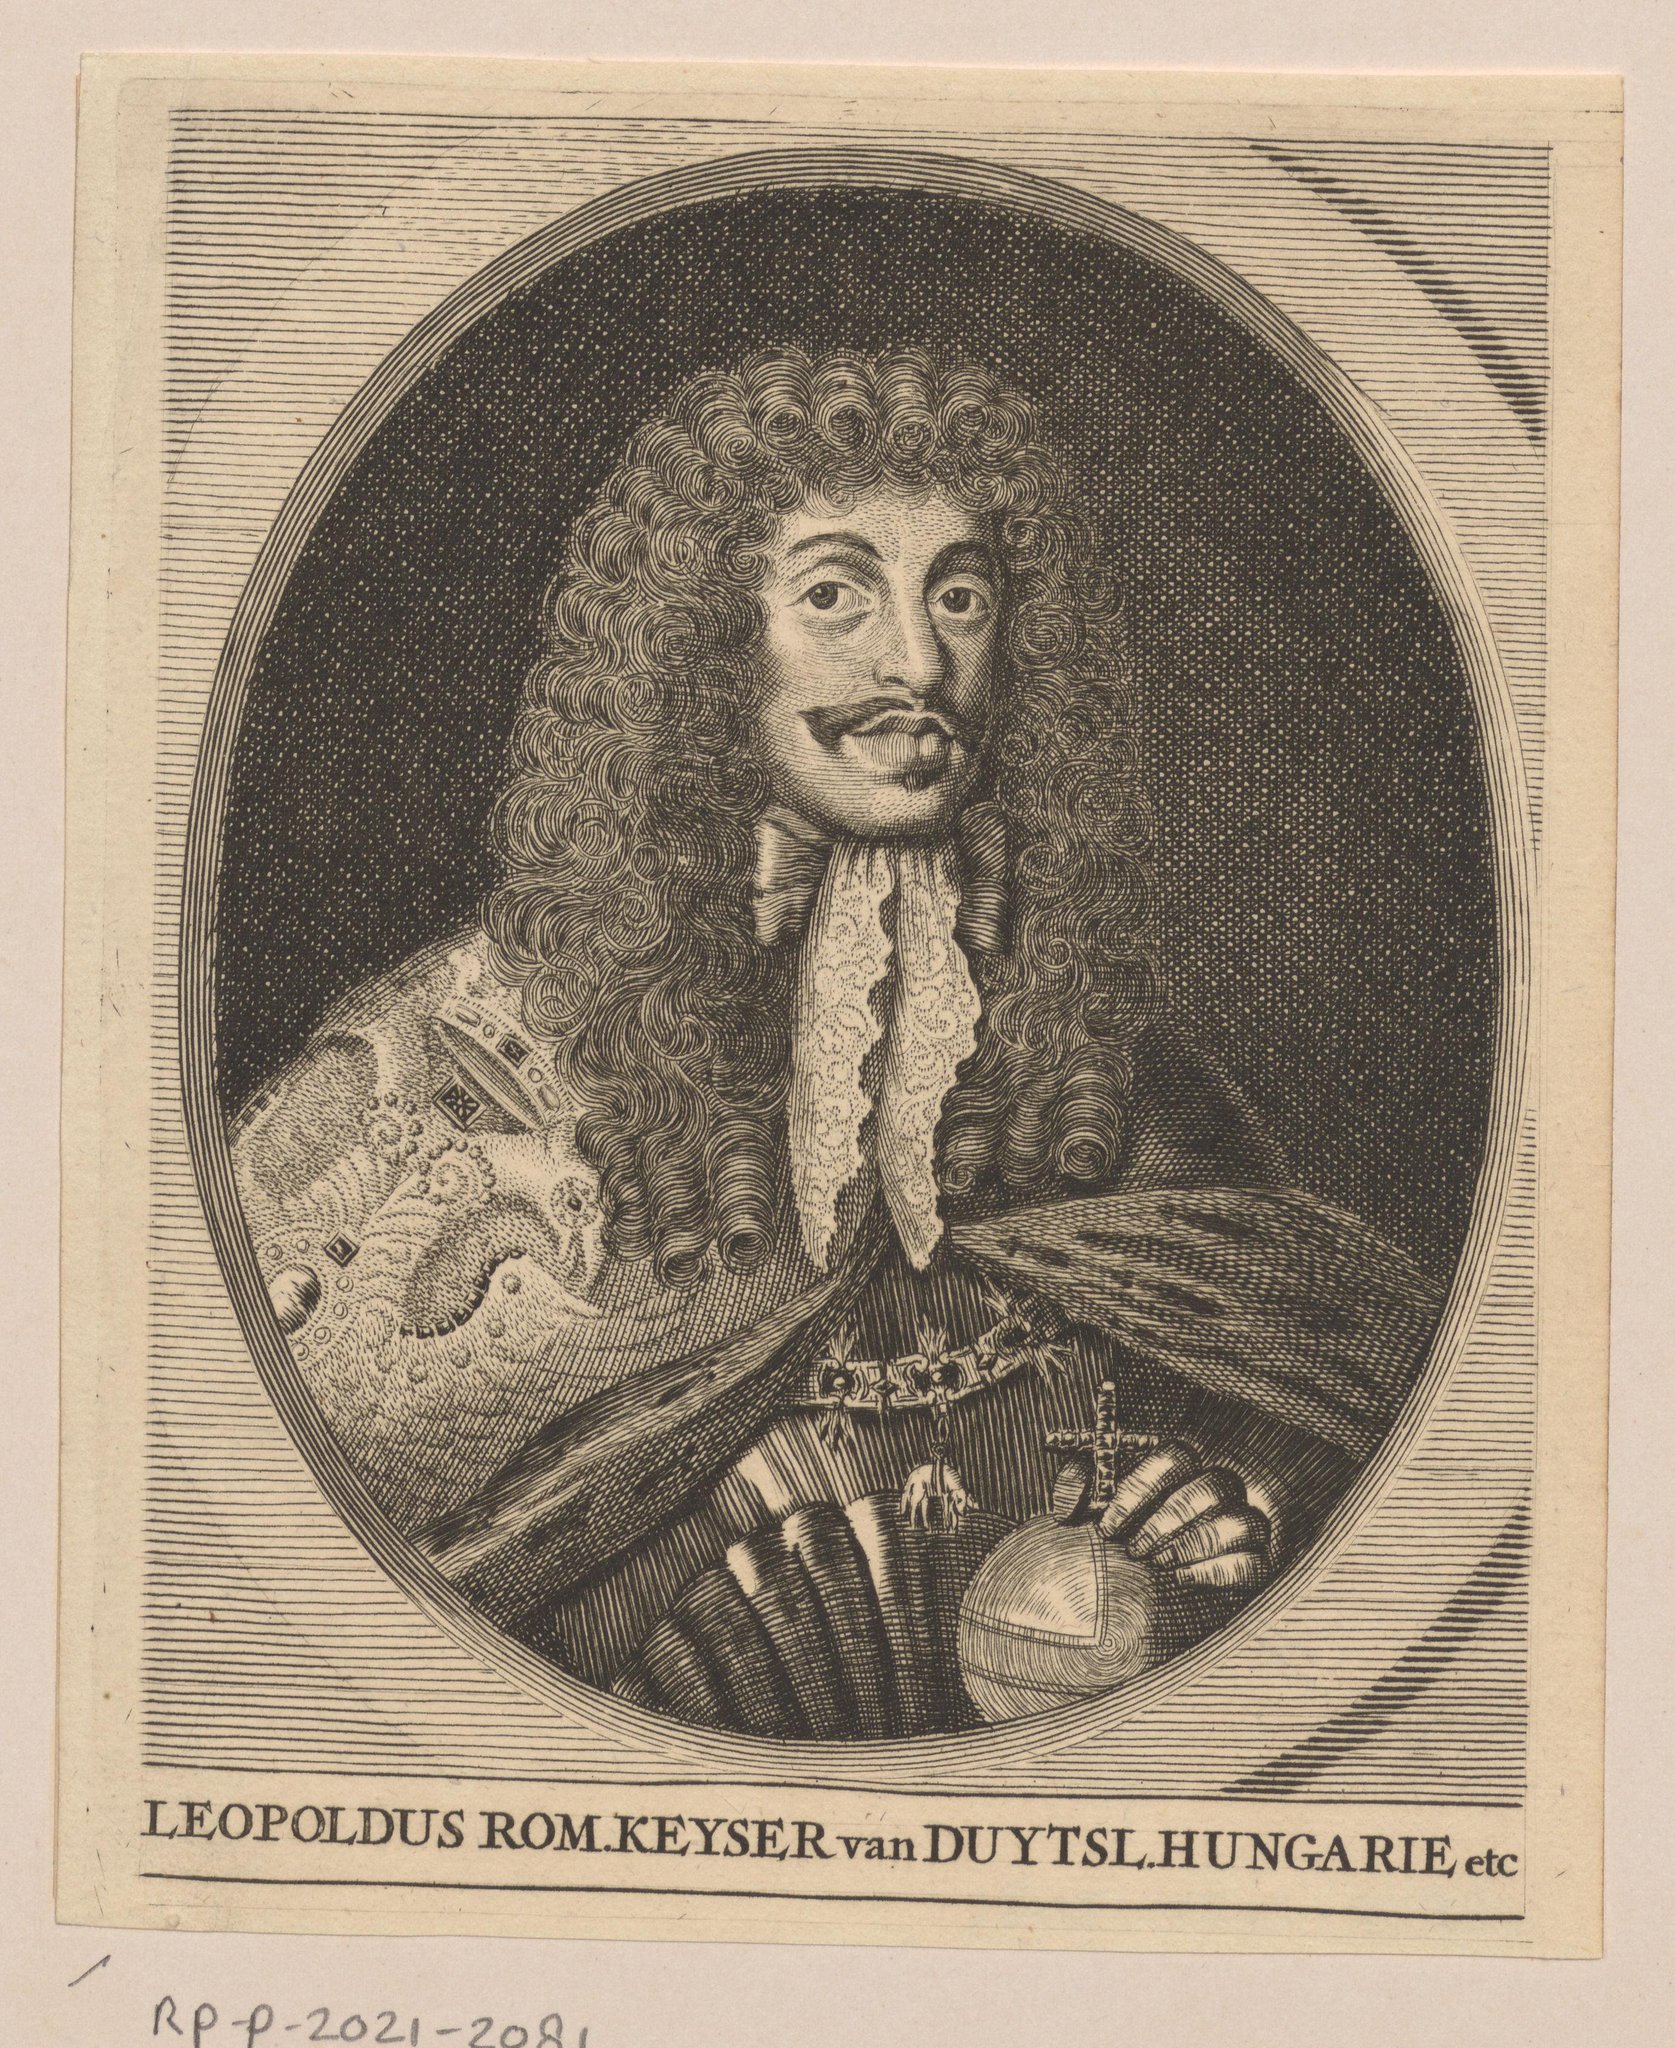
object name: book illustration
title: Portret van keizer Leopold I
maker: Anonymous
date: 1689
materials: paper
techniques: engraving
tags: vienna, leopold i (keizer van duitsland), orb (symbol of sovereignty; sphere with cross on top), imperial mantle (symbol of sovereignty), historical persons, emperor, knighthood order of the golden fleece - insignia of a knighthood order, e.g.: badge, chain (with name of order)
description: Prent waarschijnlijk uit: Engelands Gods-Dienst en Vryheid Hersteld (...). Amsterdam: Marcus Doornik, 1689.